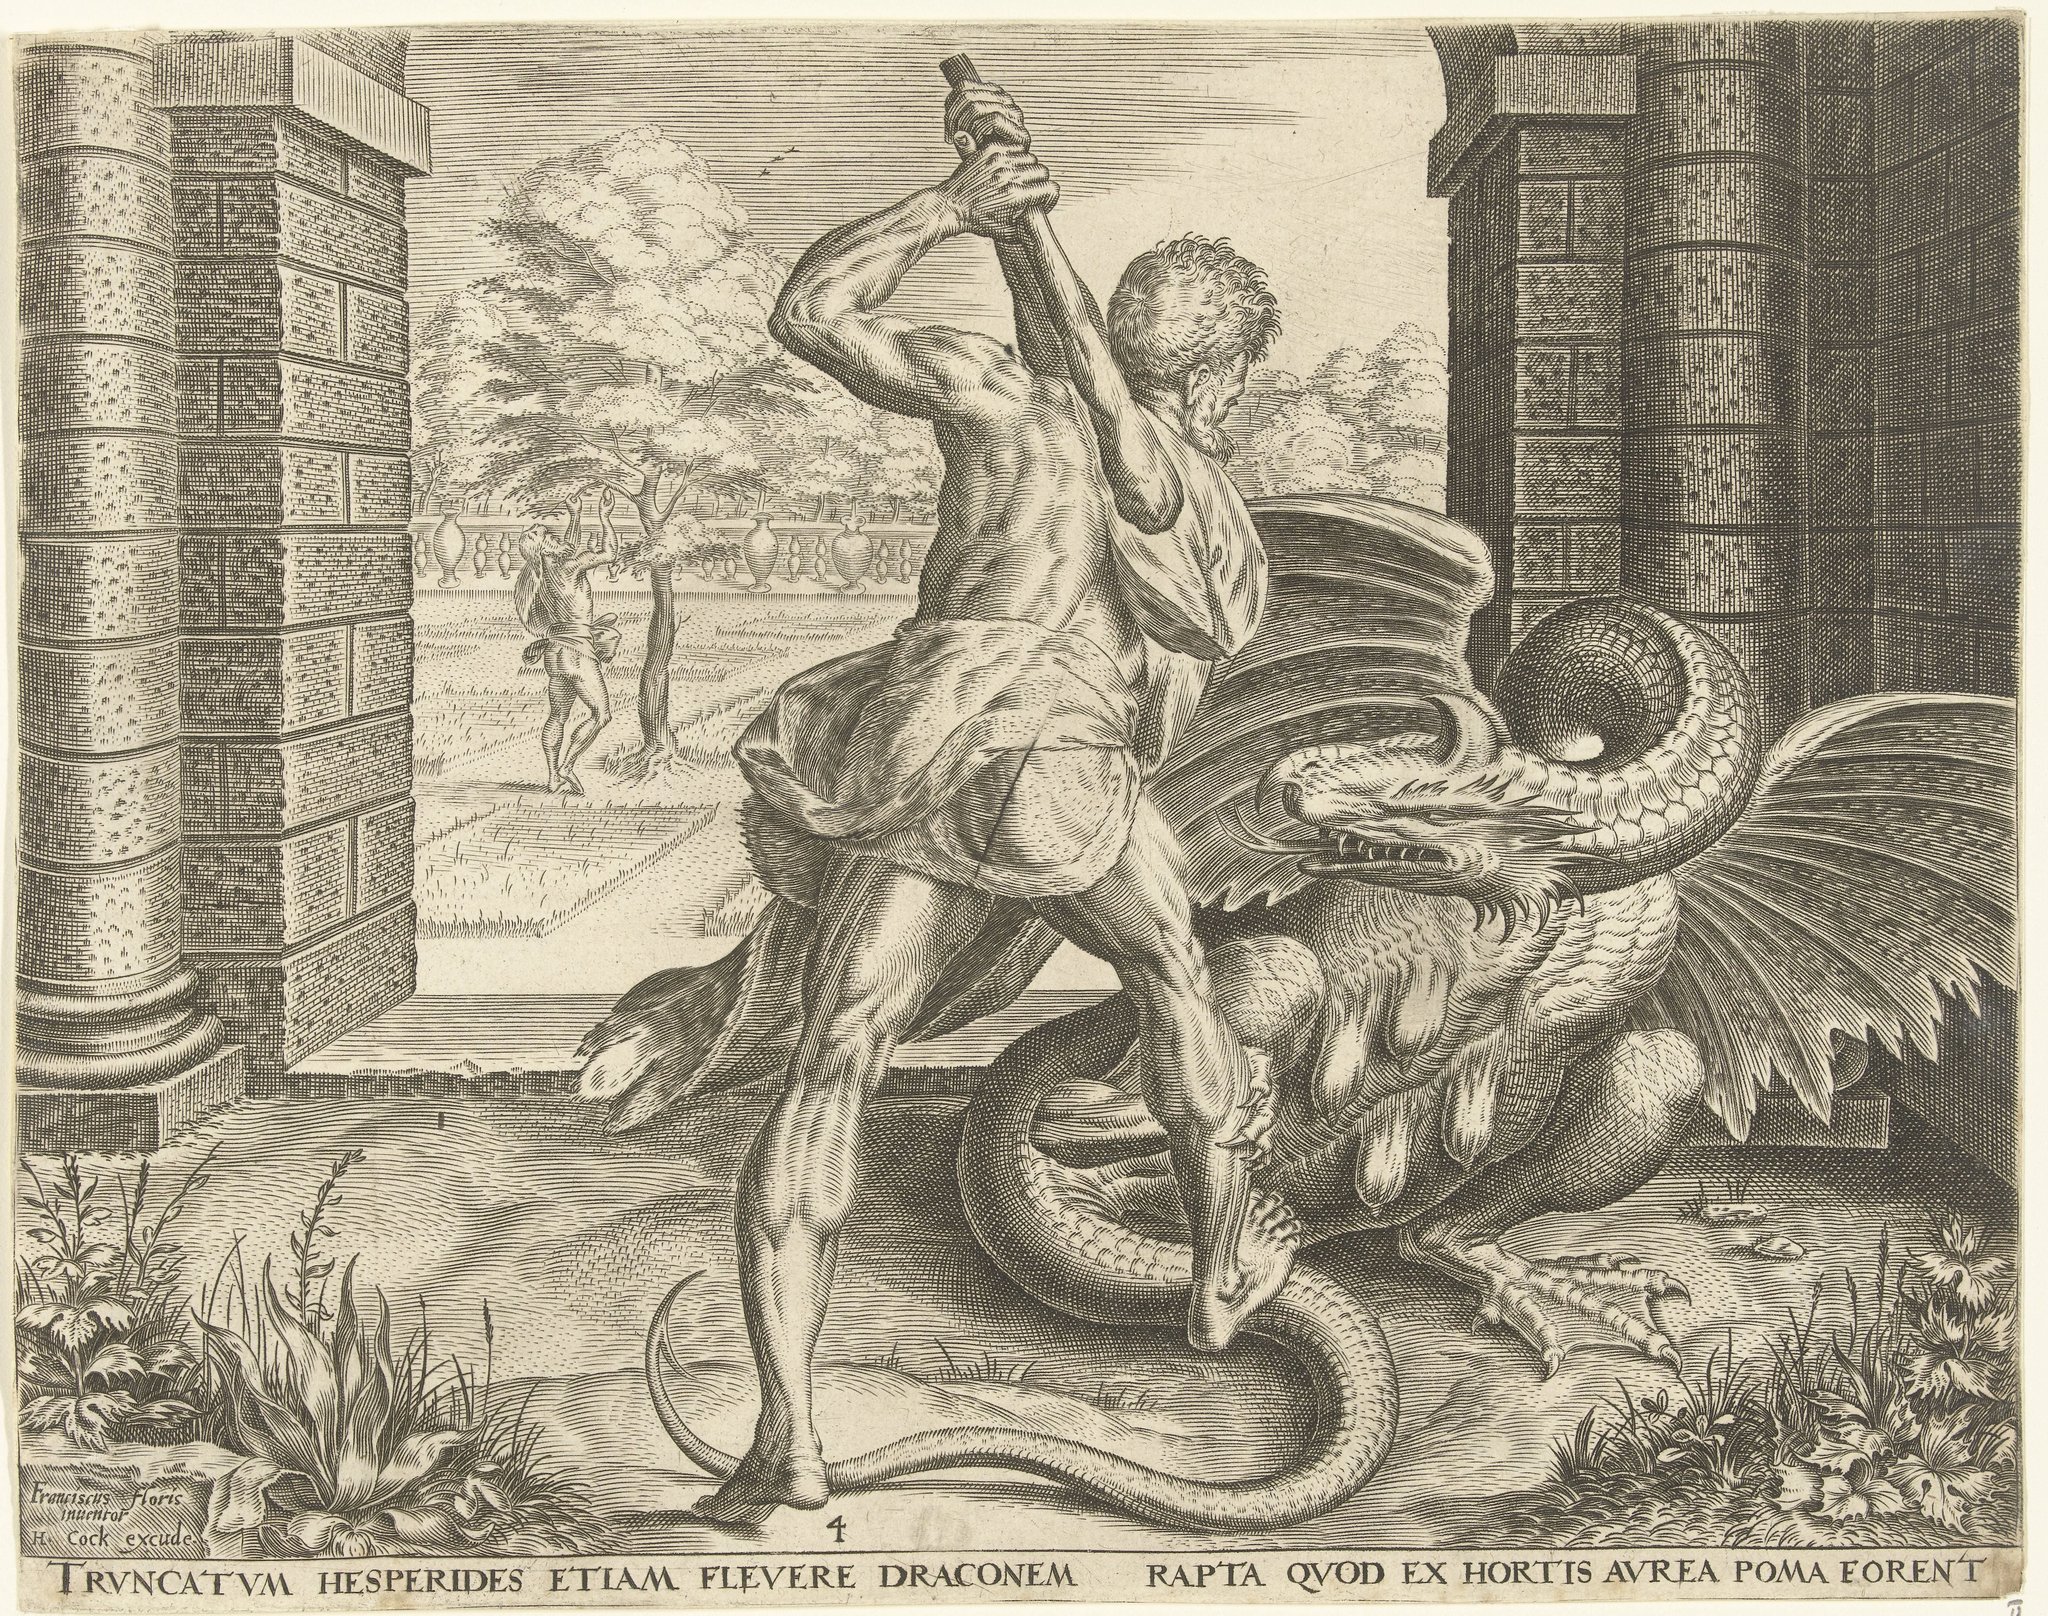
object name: print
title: Werken van Hercules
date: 1563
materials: paper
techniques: engraving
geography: antwerp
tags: the twelve labours of hercules: second series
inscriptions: collector's mark: Lugt 11, collector's mark: Lugt 10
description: Hercules steelt de gouden appelen uit de tuin van de Hesperiden. Met zijn knots verslaat hij de serpent Ladon die de ingang van de tuin bewaakt. Op de achtergrond is hij te zien hoe hij de appelen van de boom plukt.